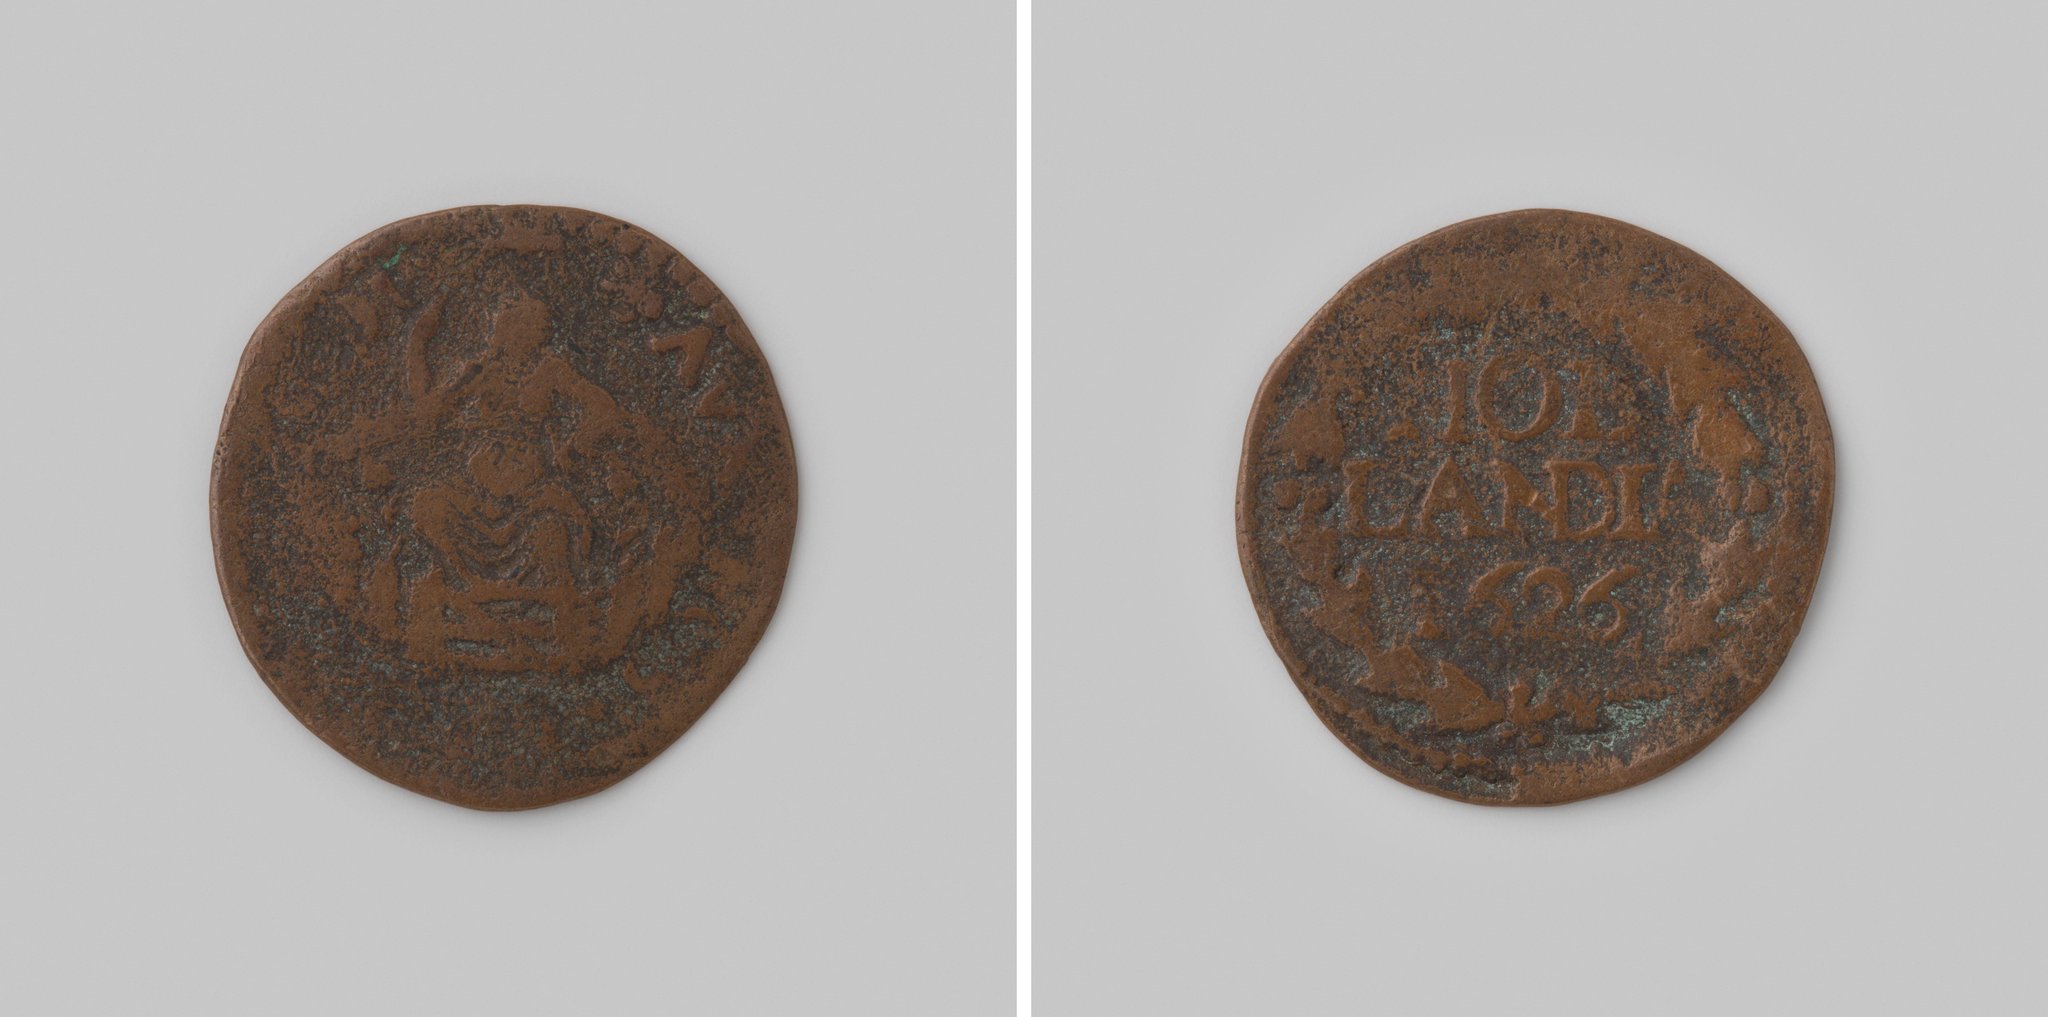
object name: coin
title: Holland, duit, 1626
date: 1626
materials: copper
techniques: striking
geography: dordrecht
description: Koperen munt. Voorzijde: binnen omheinig zittende provinciemaagd. Keerzijde: binnen krans opschrift: provincienaam in twee regels, waaronder jaartal